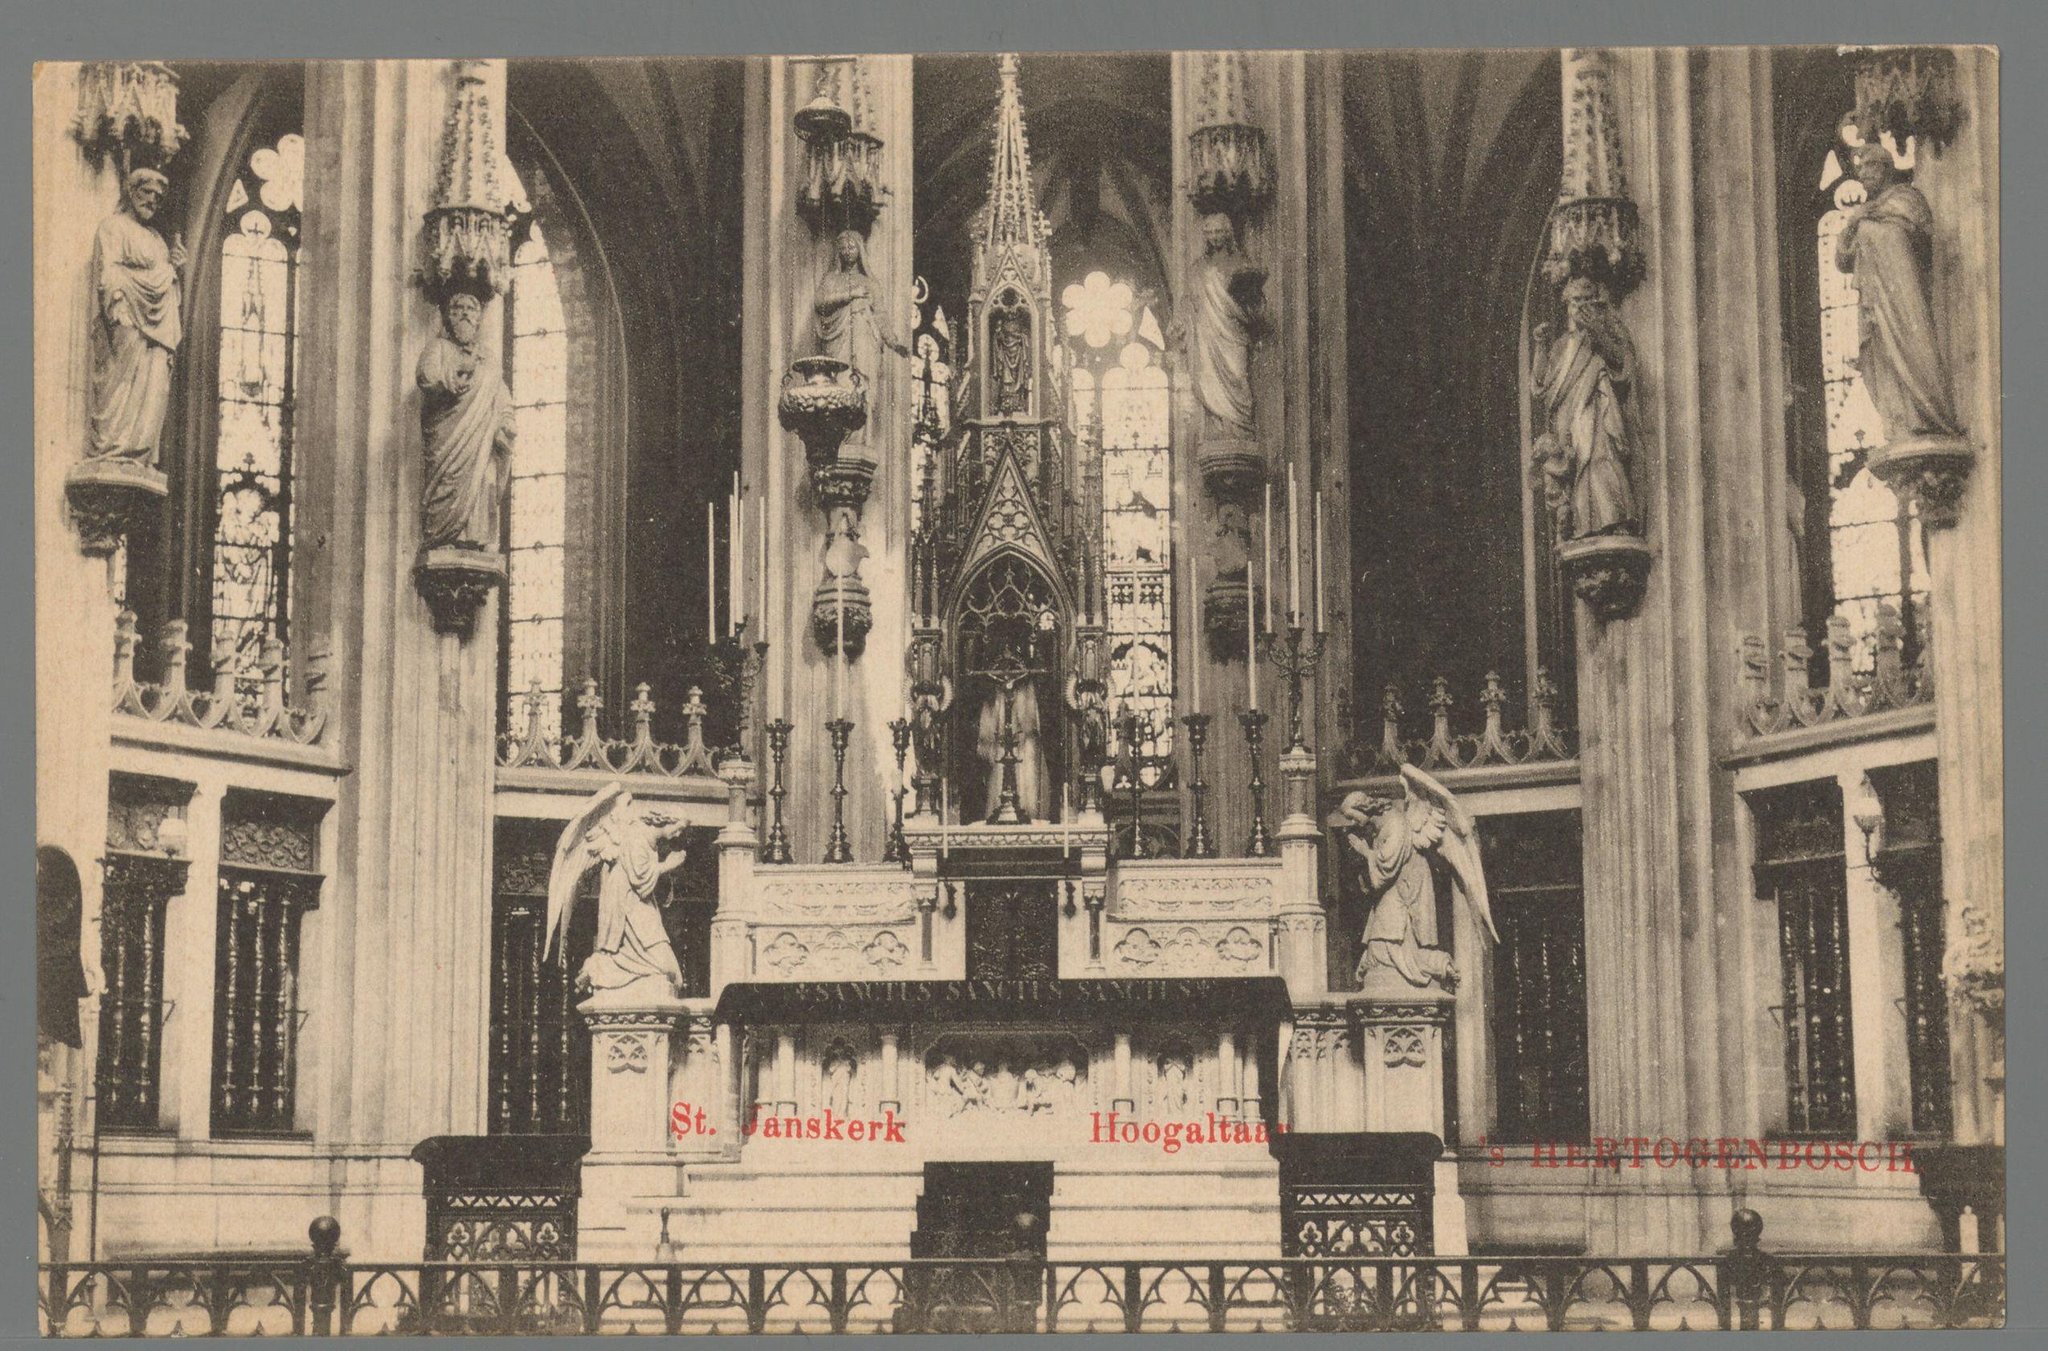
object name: ansichtkaart, prentbriefkaart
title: St. Janskerk. Hoogaltaar. 's Hertogenbosch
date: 1905-1927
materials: cardboard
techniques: photograph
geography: haarlem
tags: interior of church, altar with altar-piece